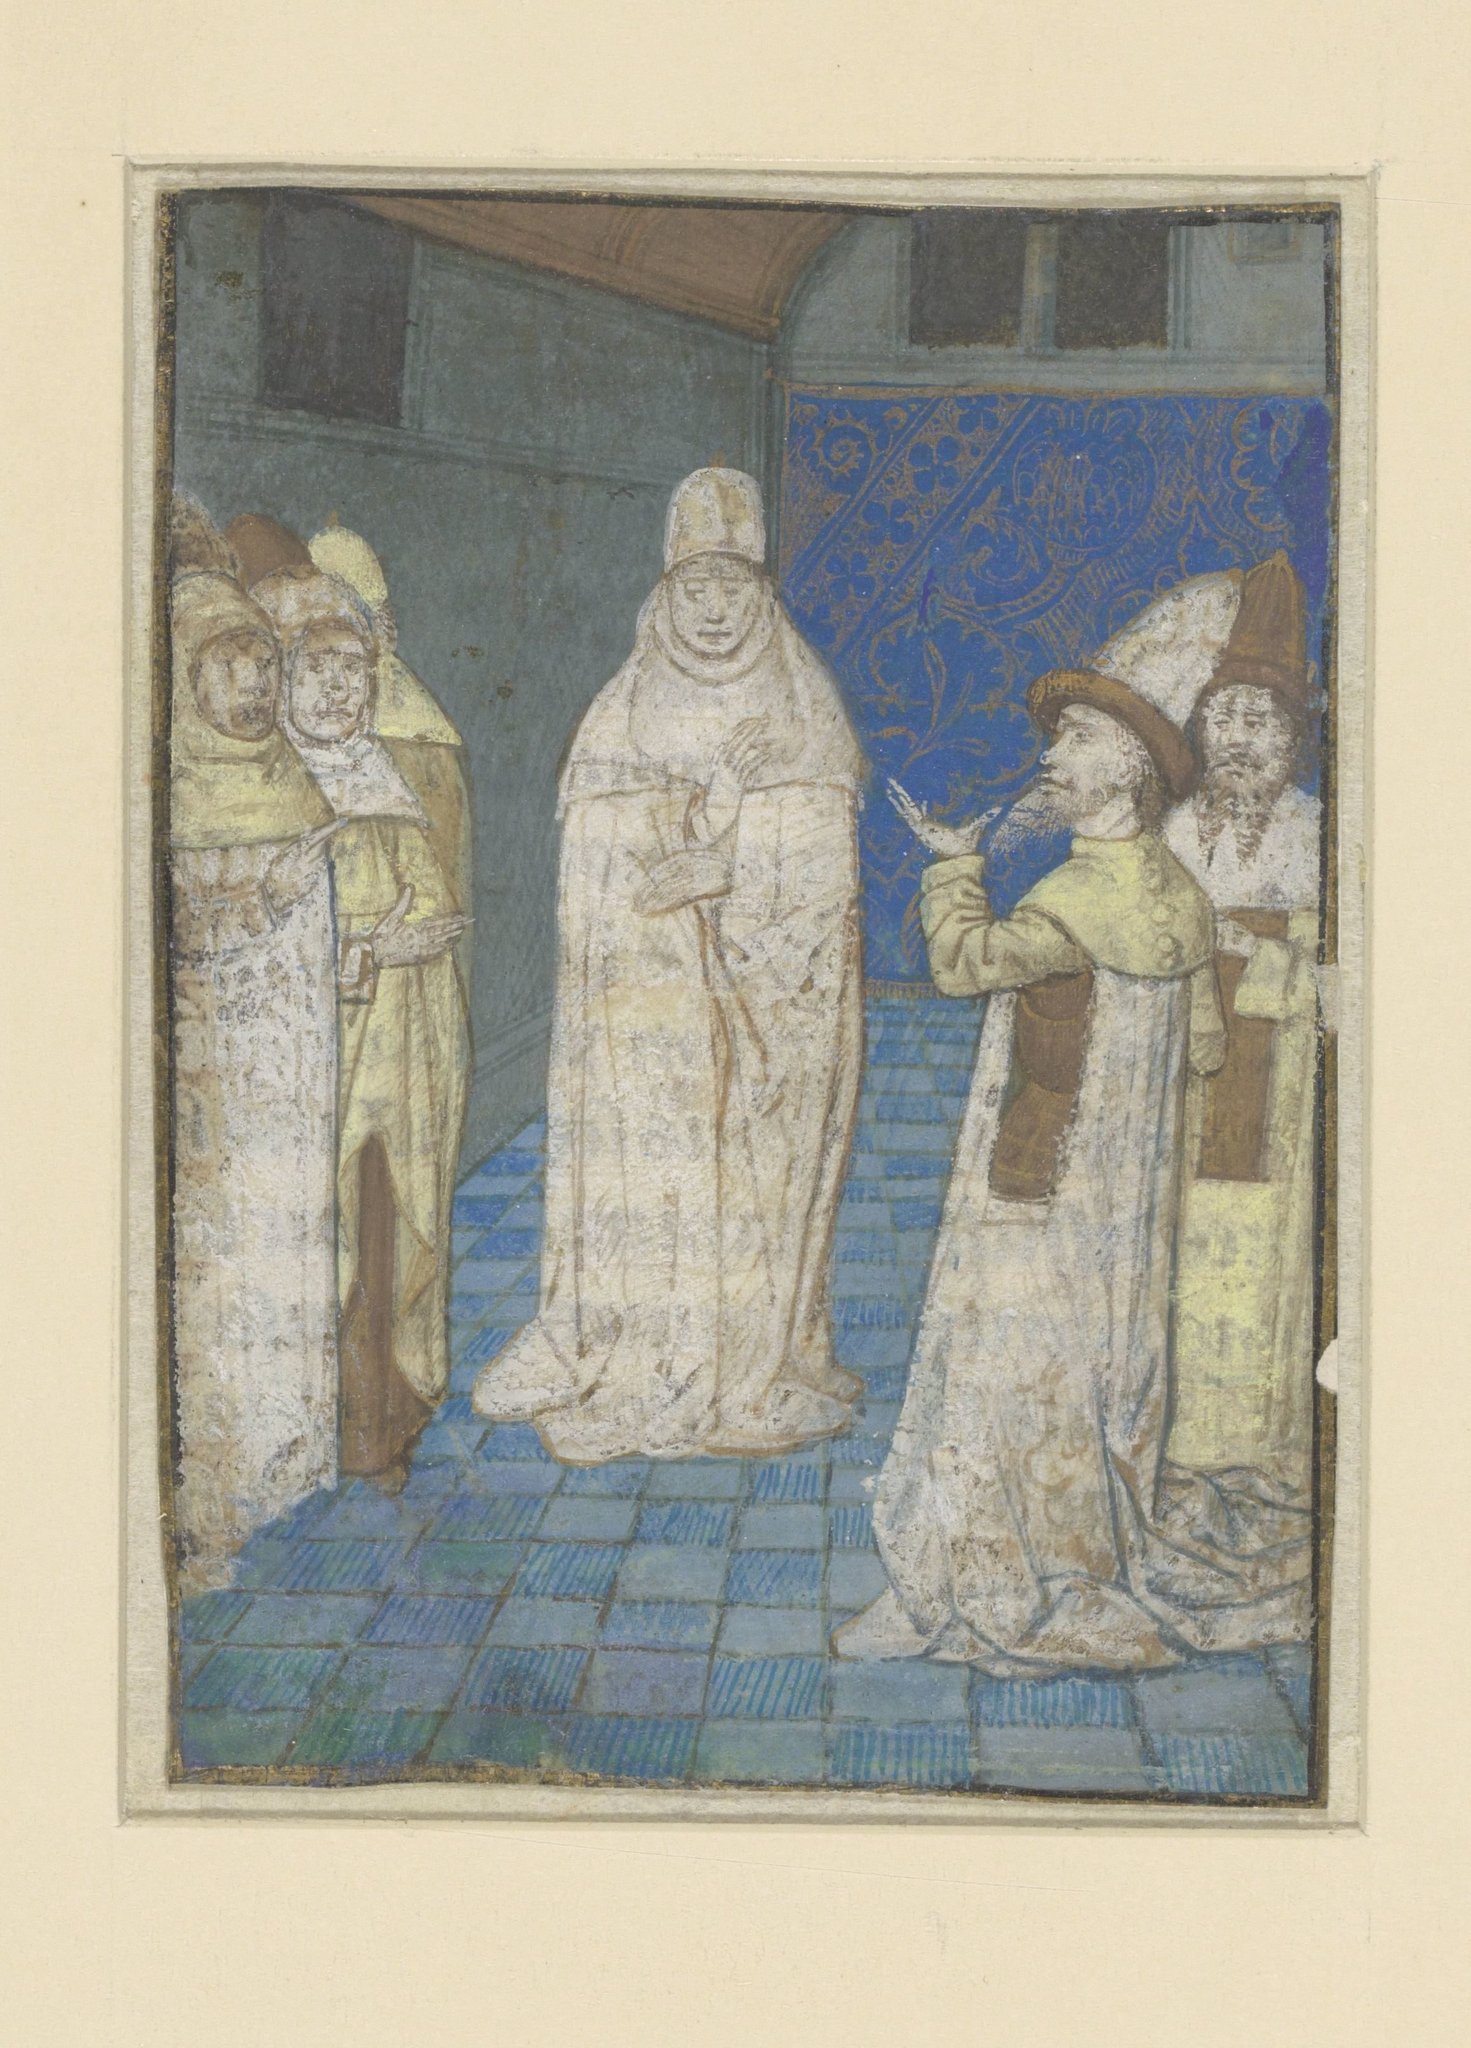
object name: miniature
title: Boccacio bemiddelt in een discussie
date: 1470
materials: paint, parchment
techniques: brush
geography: loire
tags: giovanni boccaccio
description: De lotgevallen van edele mannen en vrouwen: Boccacio bemiddelt in een discussie. Gebaseerd op Bocciacio's 'Des cas des nobles hommes et femmes' (De lotgevallen van edele mannen en vrouwen).